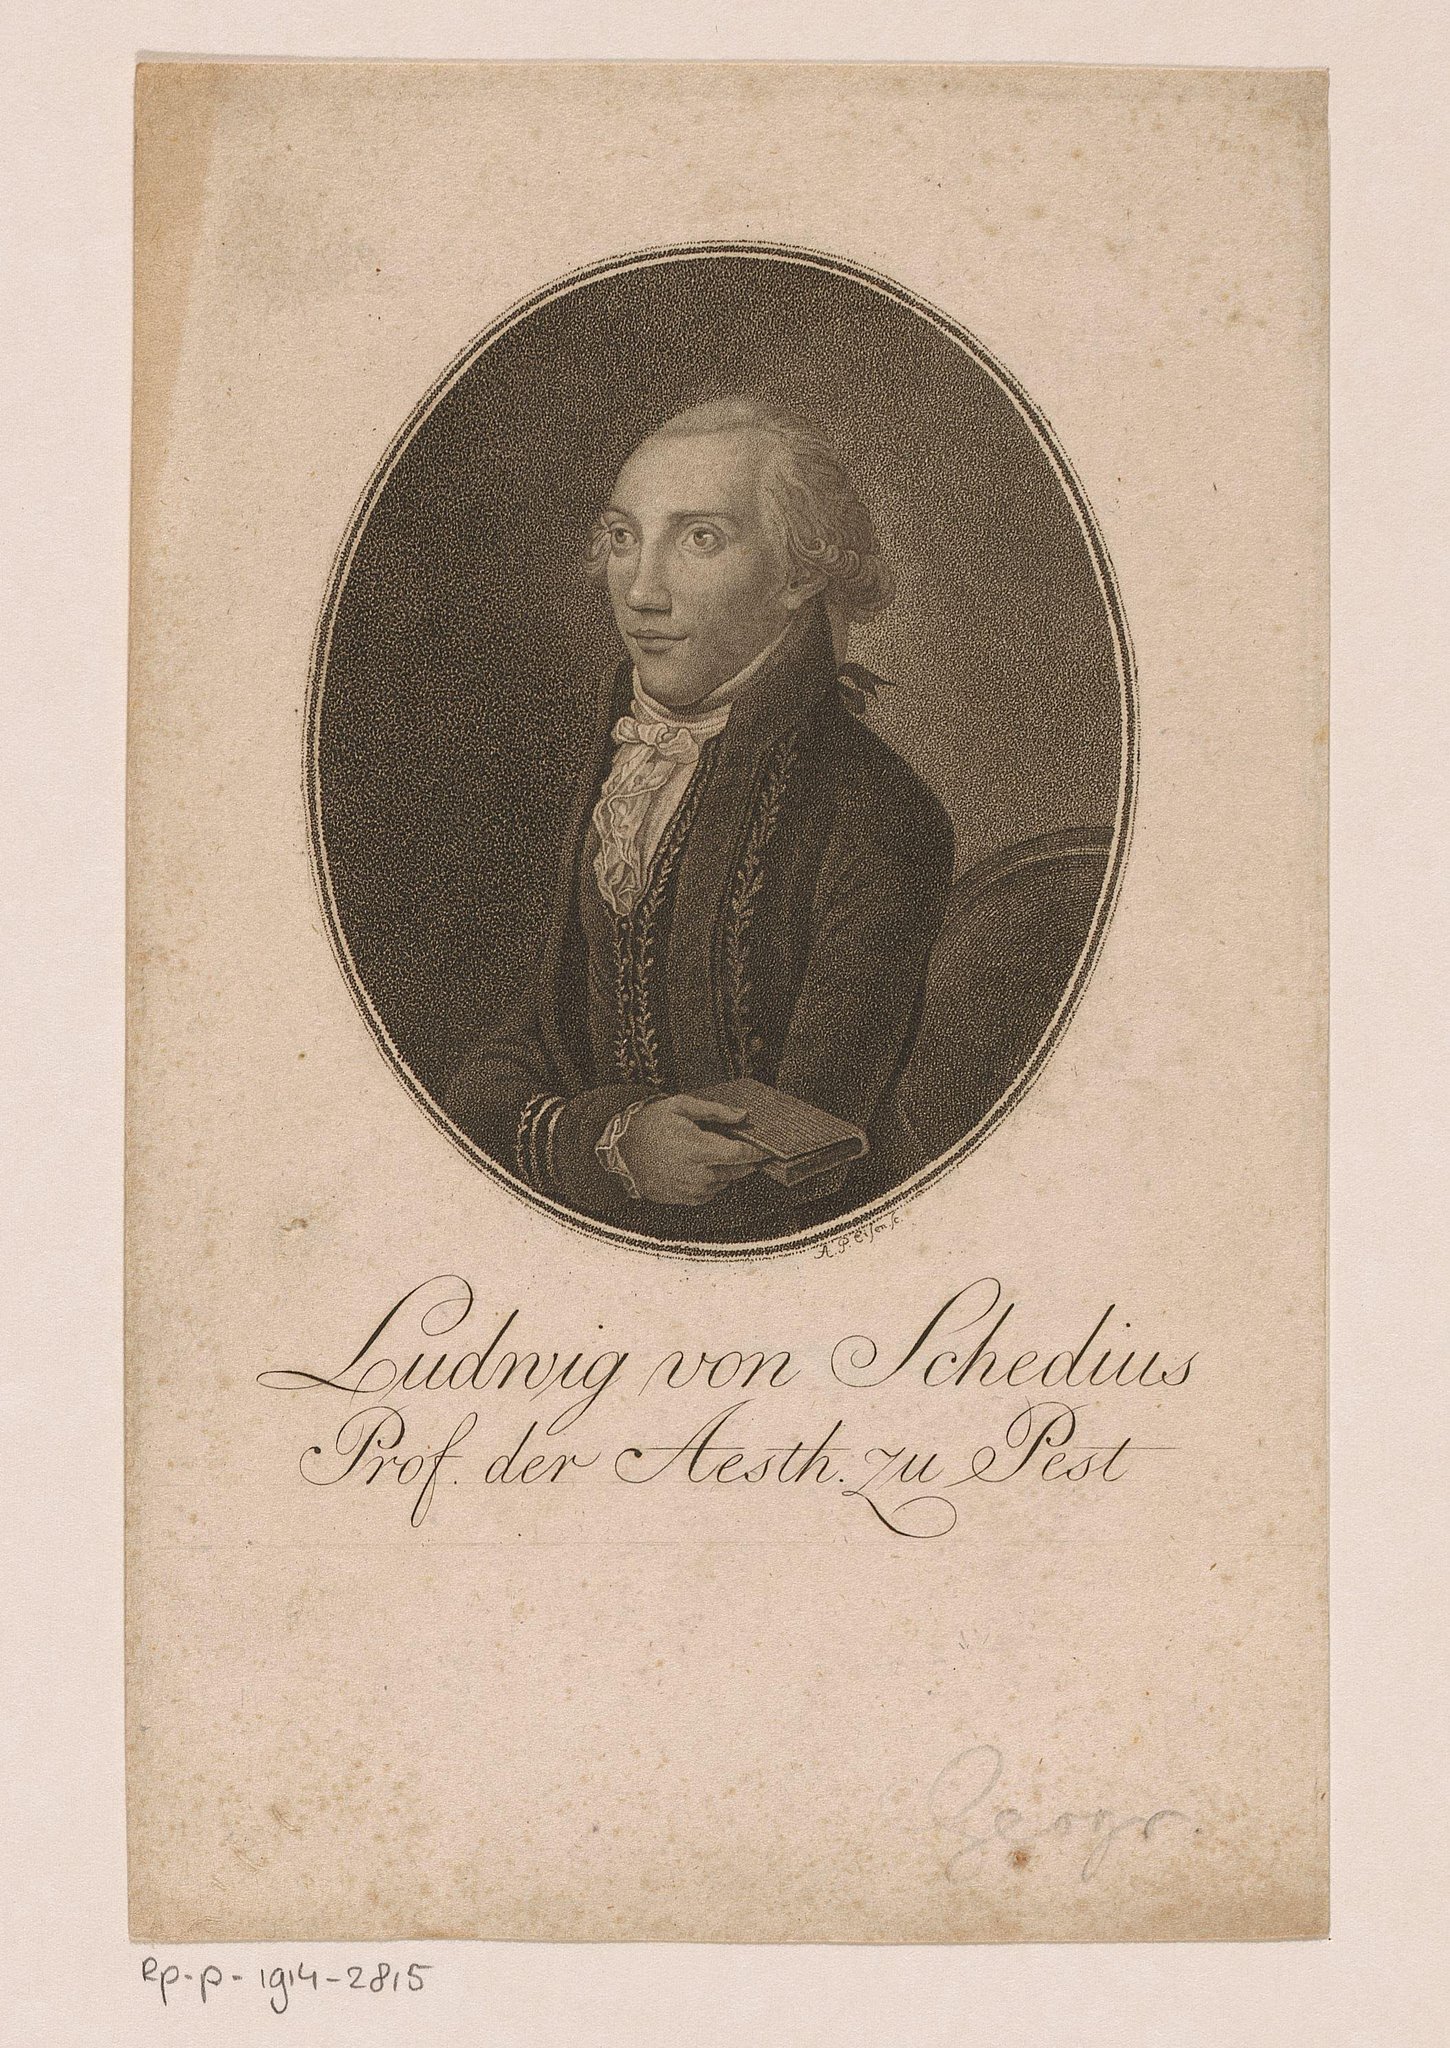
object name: print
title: Portret van Ludwig von Schedius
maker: anton paul eisen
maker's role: print maker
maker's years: 1777-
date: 1787-1843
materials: paper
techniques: stippling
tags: historical persons, book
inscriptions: collector's mark: Lugt 2228